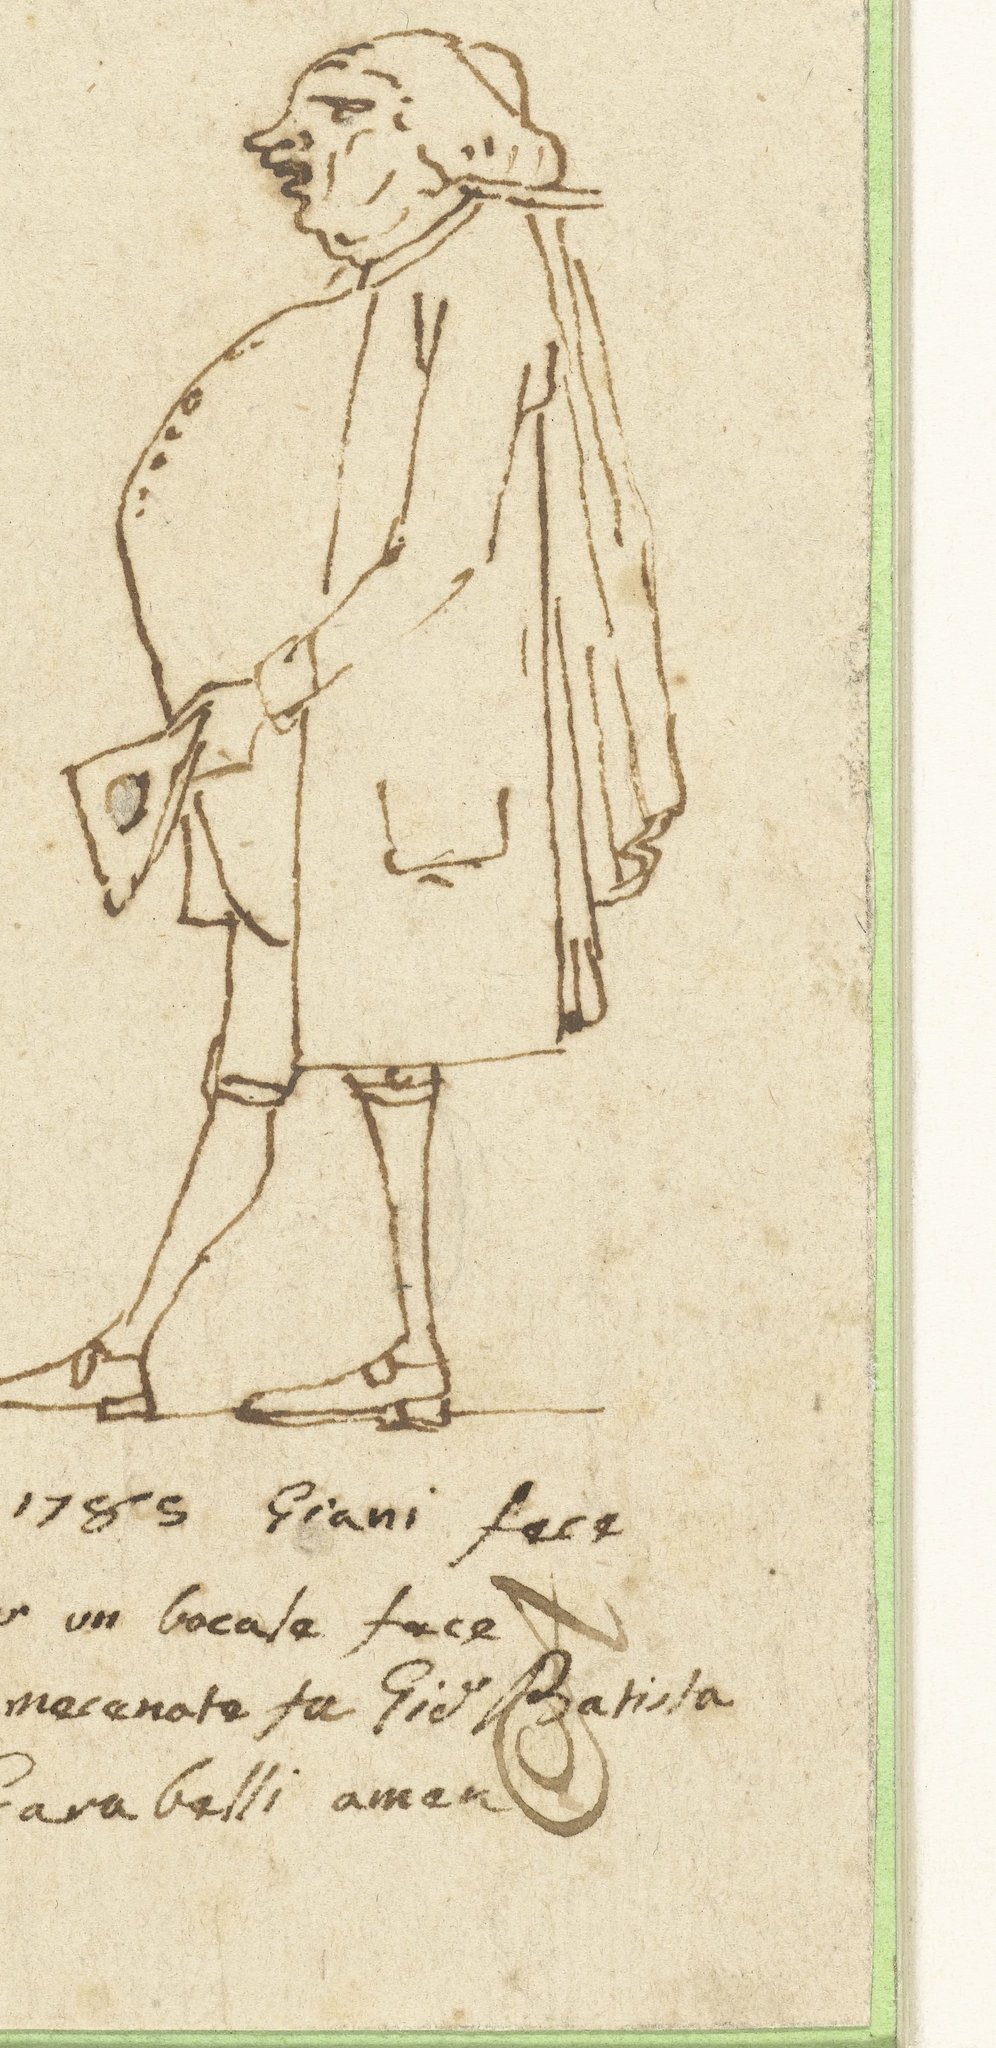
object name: caricature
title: Karikatuur van Giovanni Basttista Scarabelli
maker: felice giani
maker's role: draughtsman, painter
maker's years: 1758-1823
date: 1785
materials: ink, paper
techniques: pen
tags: caricatures (human types), historical persons